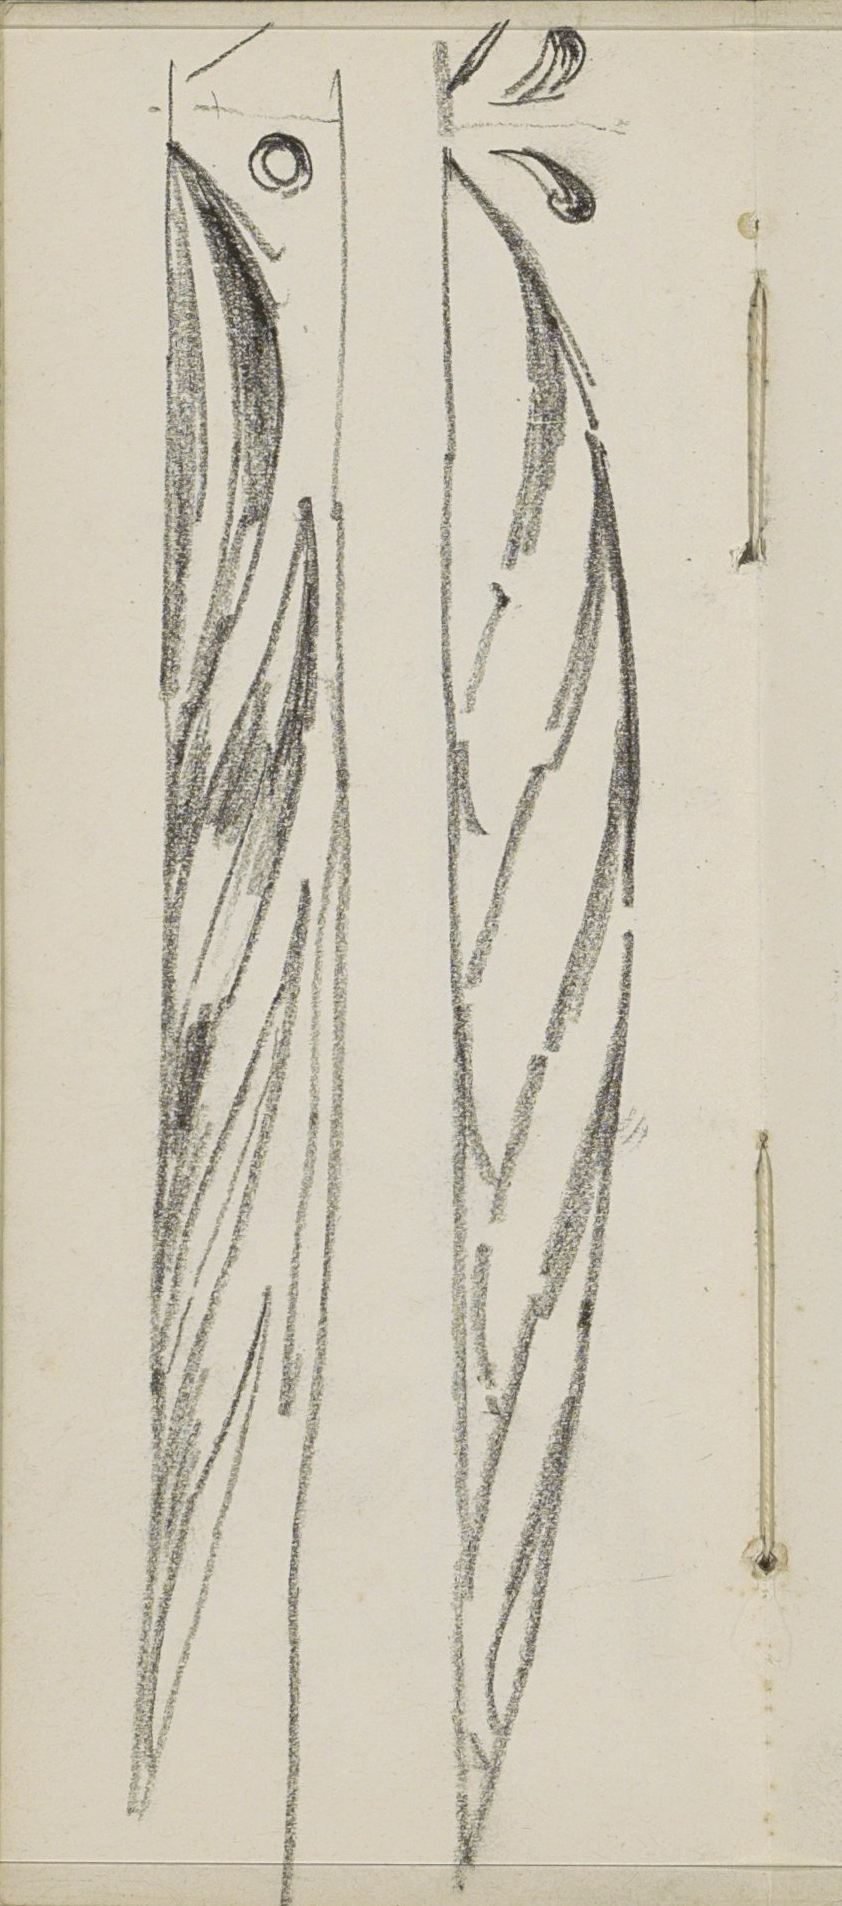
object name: sketchbook leaf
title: Ornamenten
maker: gerrit willem dijsselhof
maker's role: designer, draughtsman, print maker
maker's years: 1866-1924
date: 1876-1924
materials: chalk, paper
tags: ornaments ~ art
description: Blad 18 verso uit een schetsboek met 40 bladen.